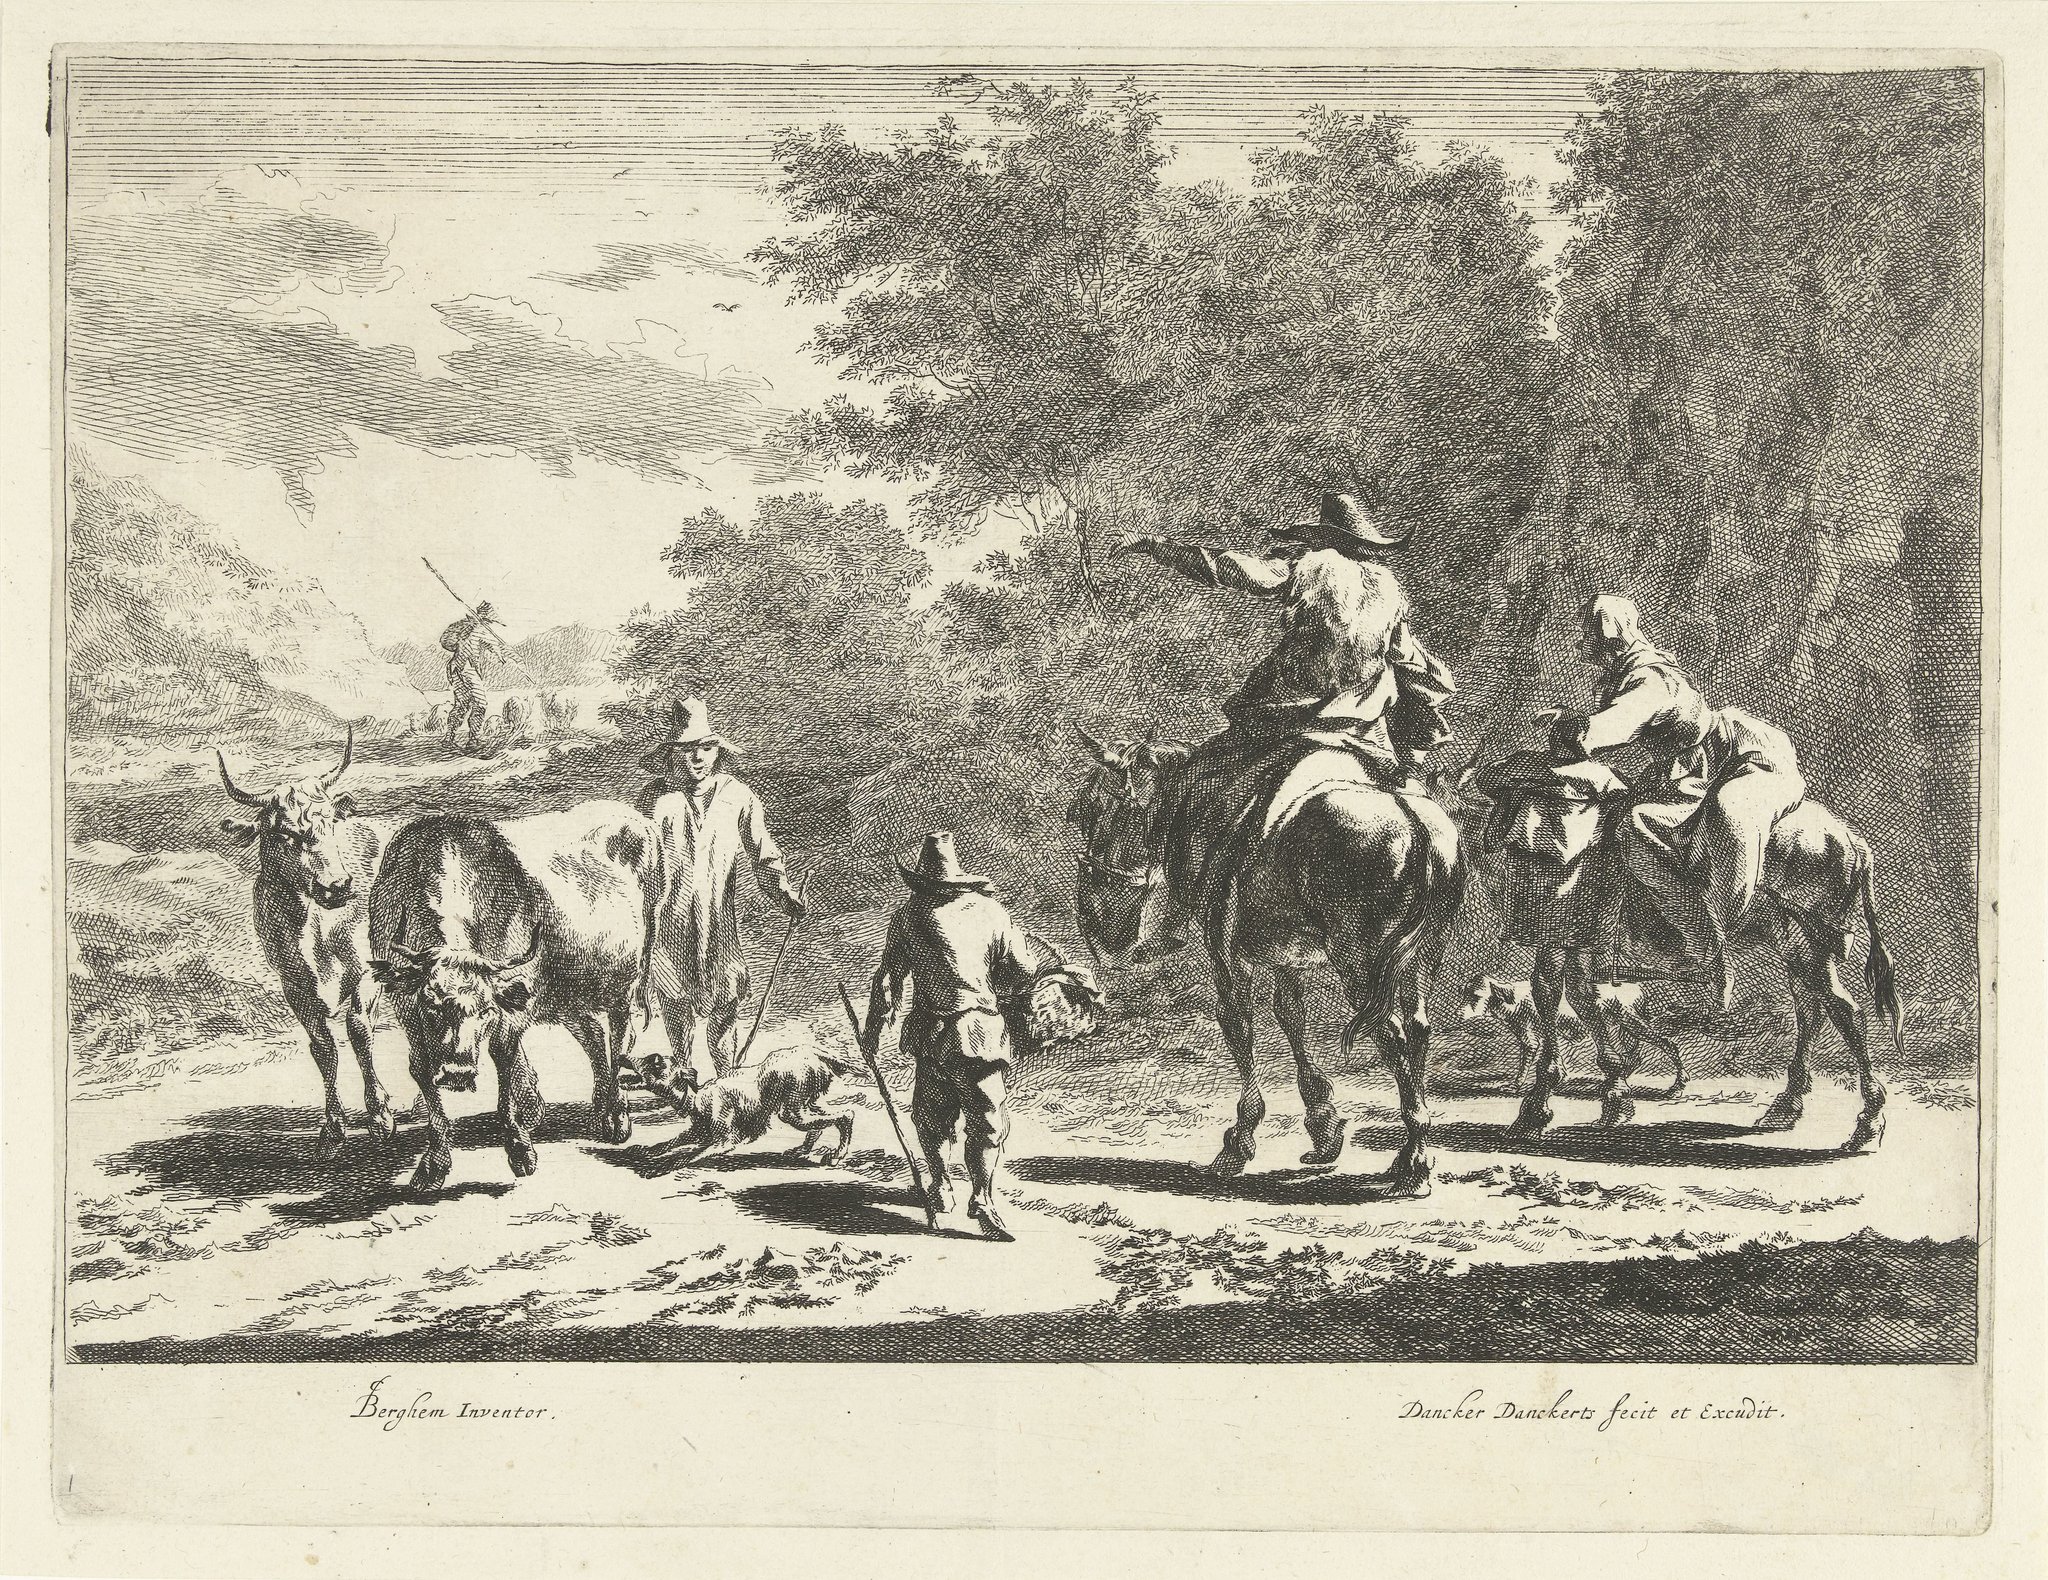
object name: print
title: Herders en vee onderweg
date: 1643-1666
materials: paper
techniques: etching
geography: amsterdam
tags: herding, herdsman, herdswoman, shepherd, shepherdess, cowherd, etc., rocks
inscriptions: collector's mark: Lugt 240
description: Prent uit serie van zes landschappen naar ontwerp van Nicolaes Pietersz. Berchem.